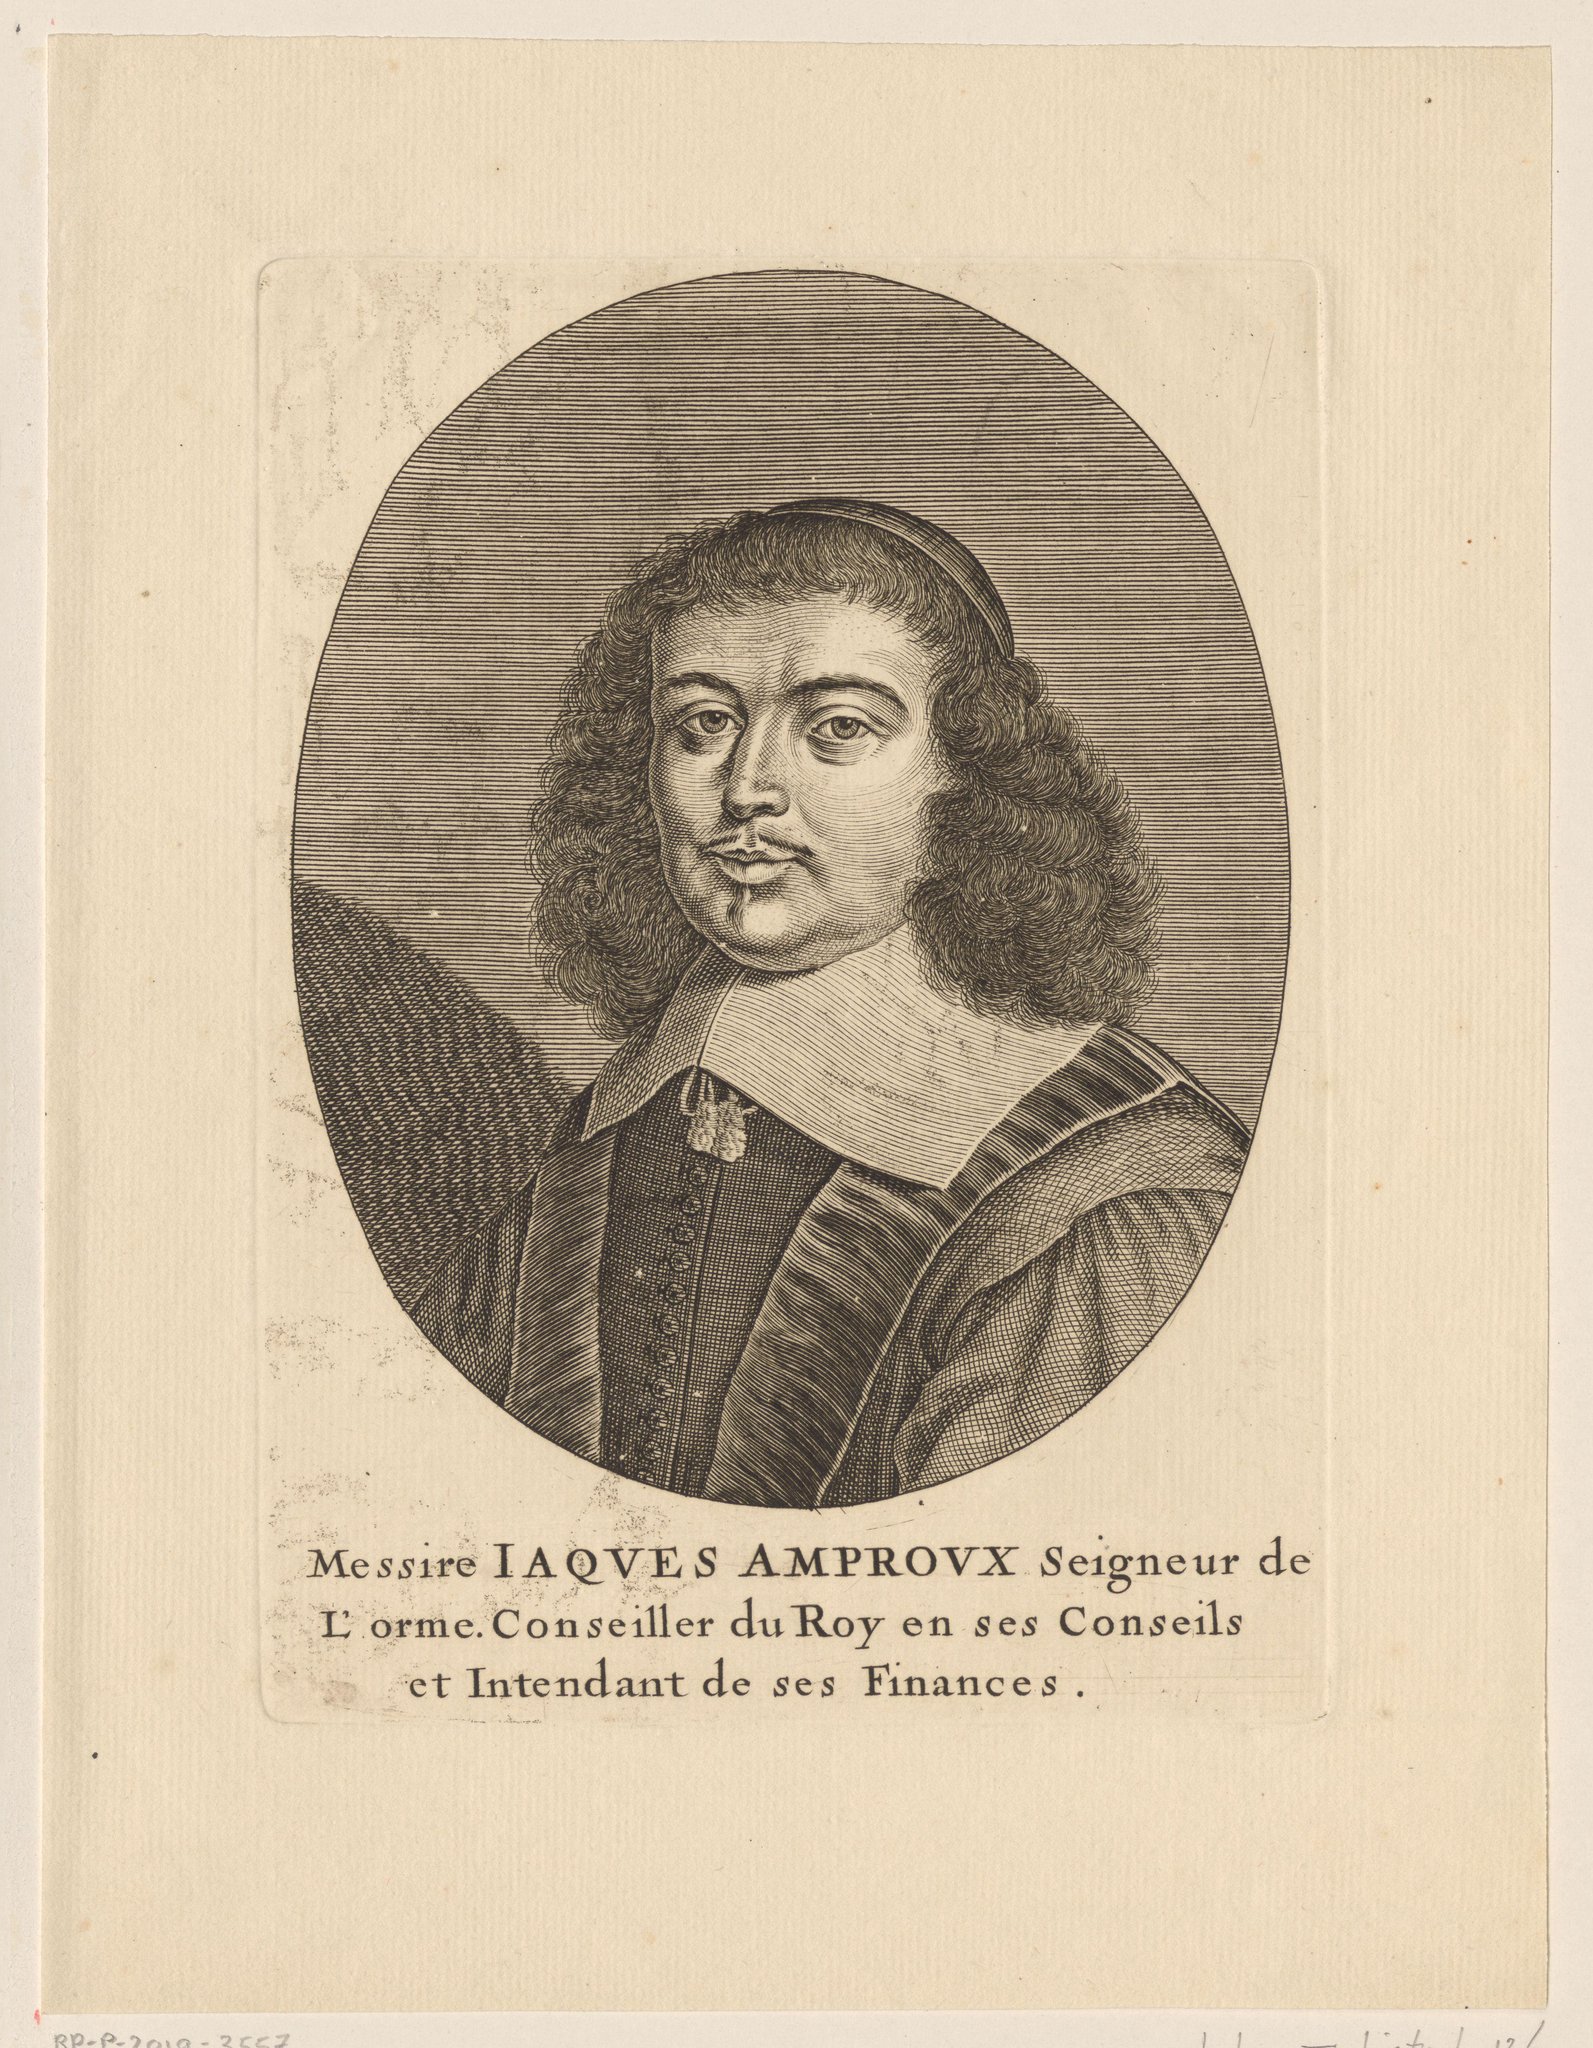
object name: print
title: Portret van Jacques Amproux de Lorme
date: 1658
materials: paper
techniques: engraving, etching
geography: rotterdam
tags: historical persons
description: Prent uit: Rochefort, Charles de en Louis de Loinvilliers de Poincy. Histoire naturelle et morale des Iles Antilles de l'Amerique. Rotterdam: Arnout Leers, 1658.